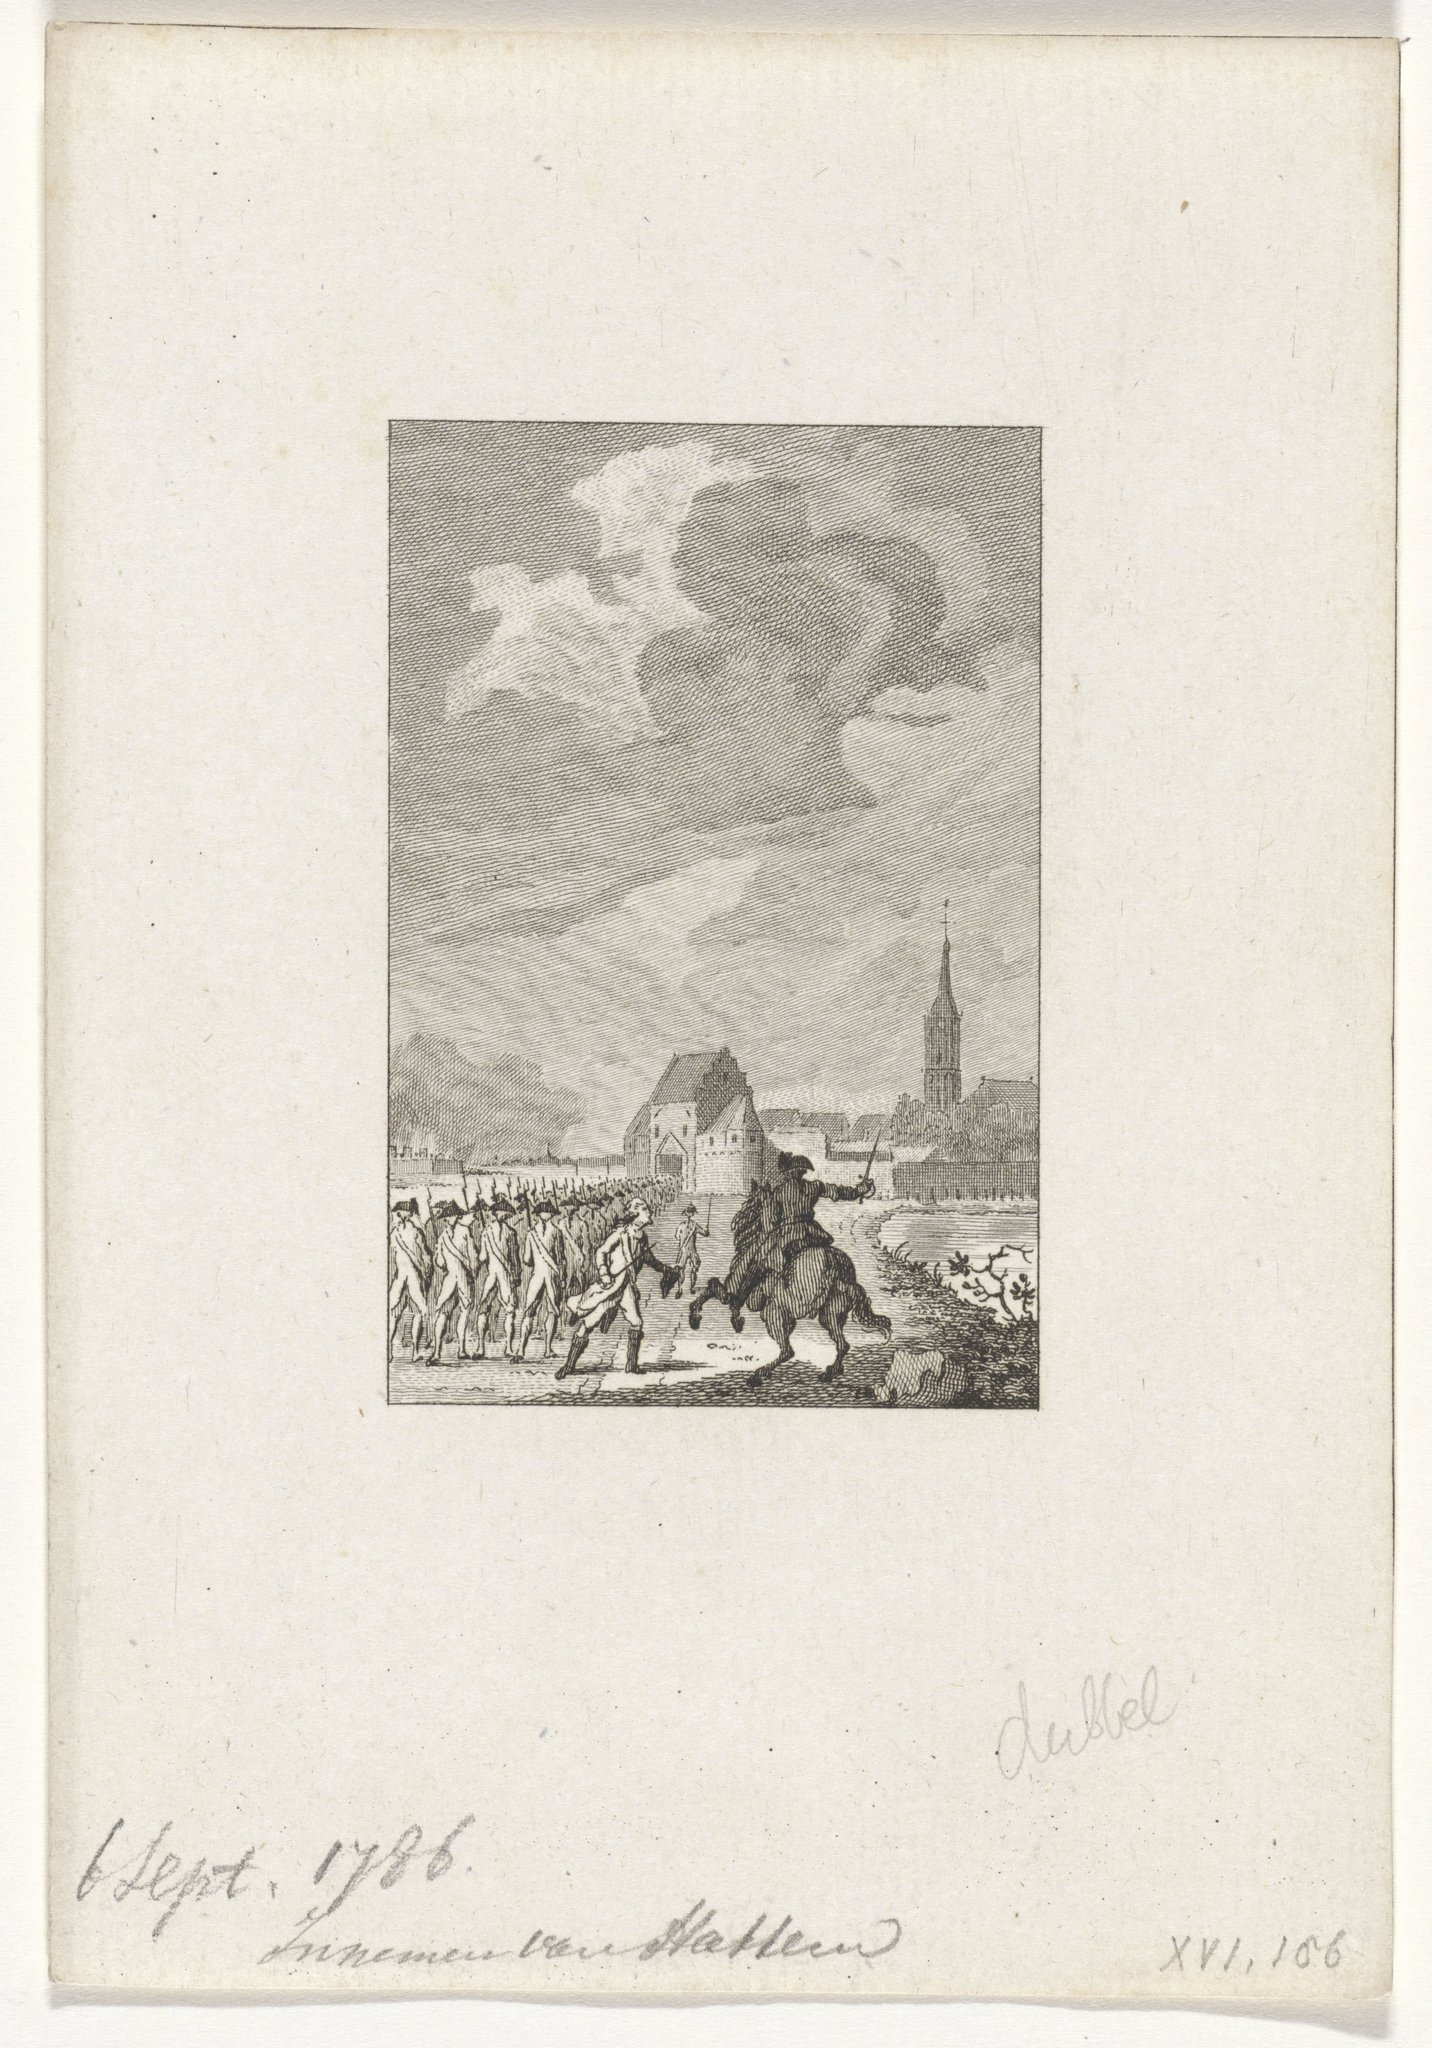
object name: print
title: Inname van Hattem, 1786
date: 1783-1795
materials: paper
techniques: etching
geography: amsterdam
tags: capture of city (after the siege)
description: Illustratie voor: J. Fokke. Geschiedenissen der Vereenigde Nederlanden voor de vaderlandsche jeugd. Amsterdam: Johannes Allart, 1783-1795, 25 delen. deel XVI pl. XI.